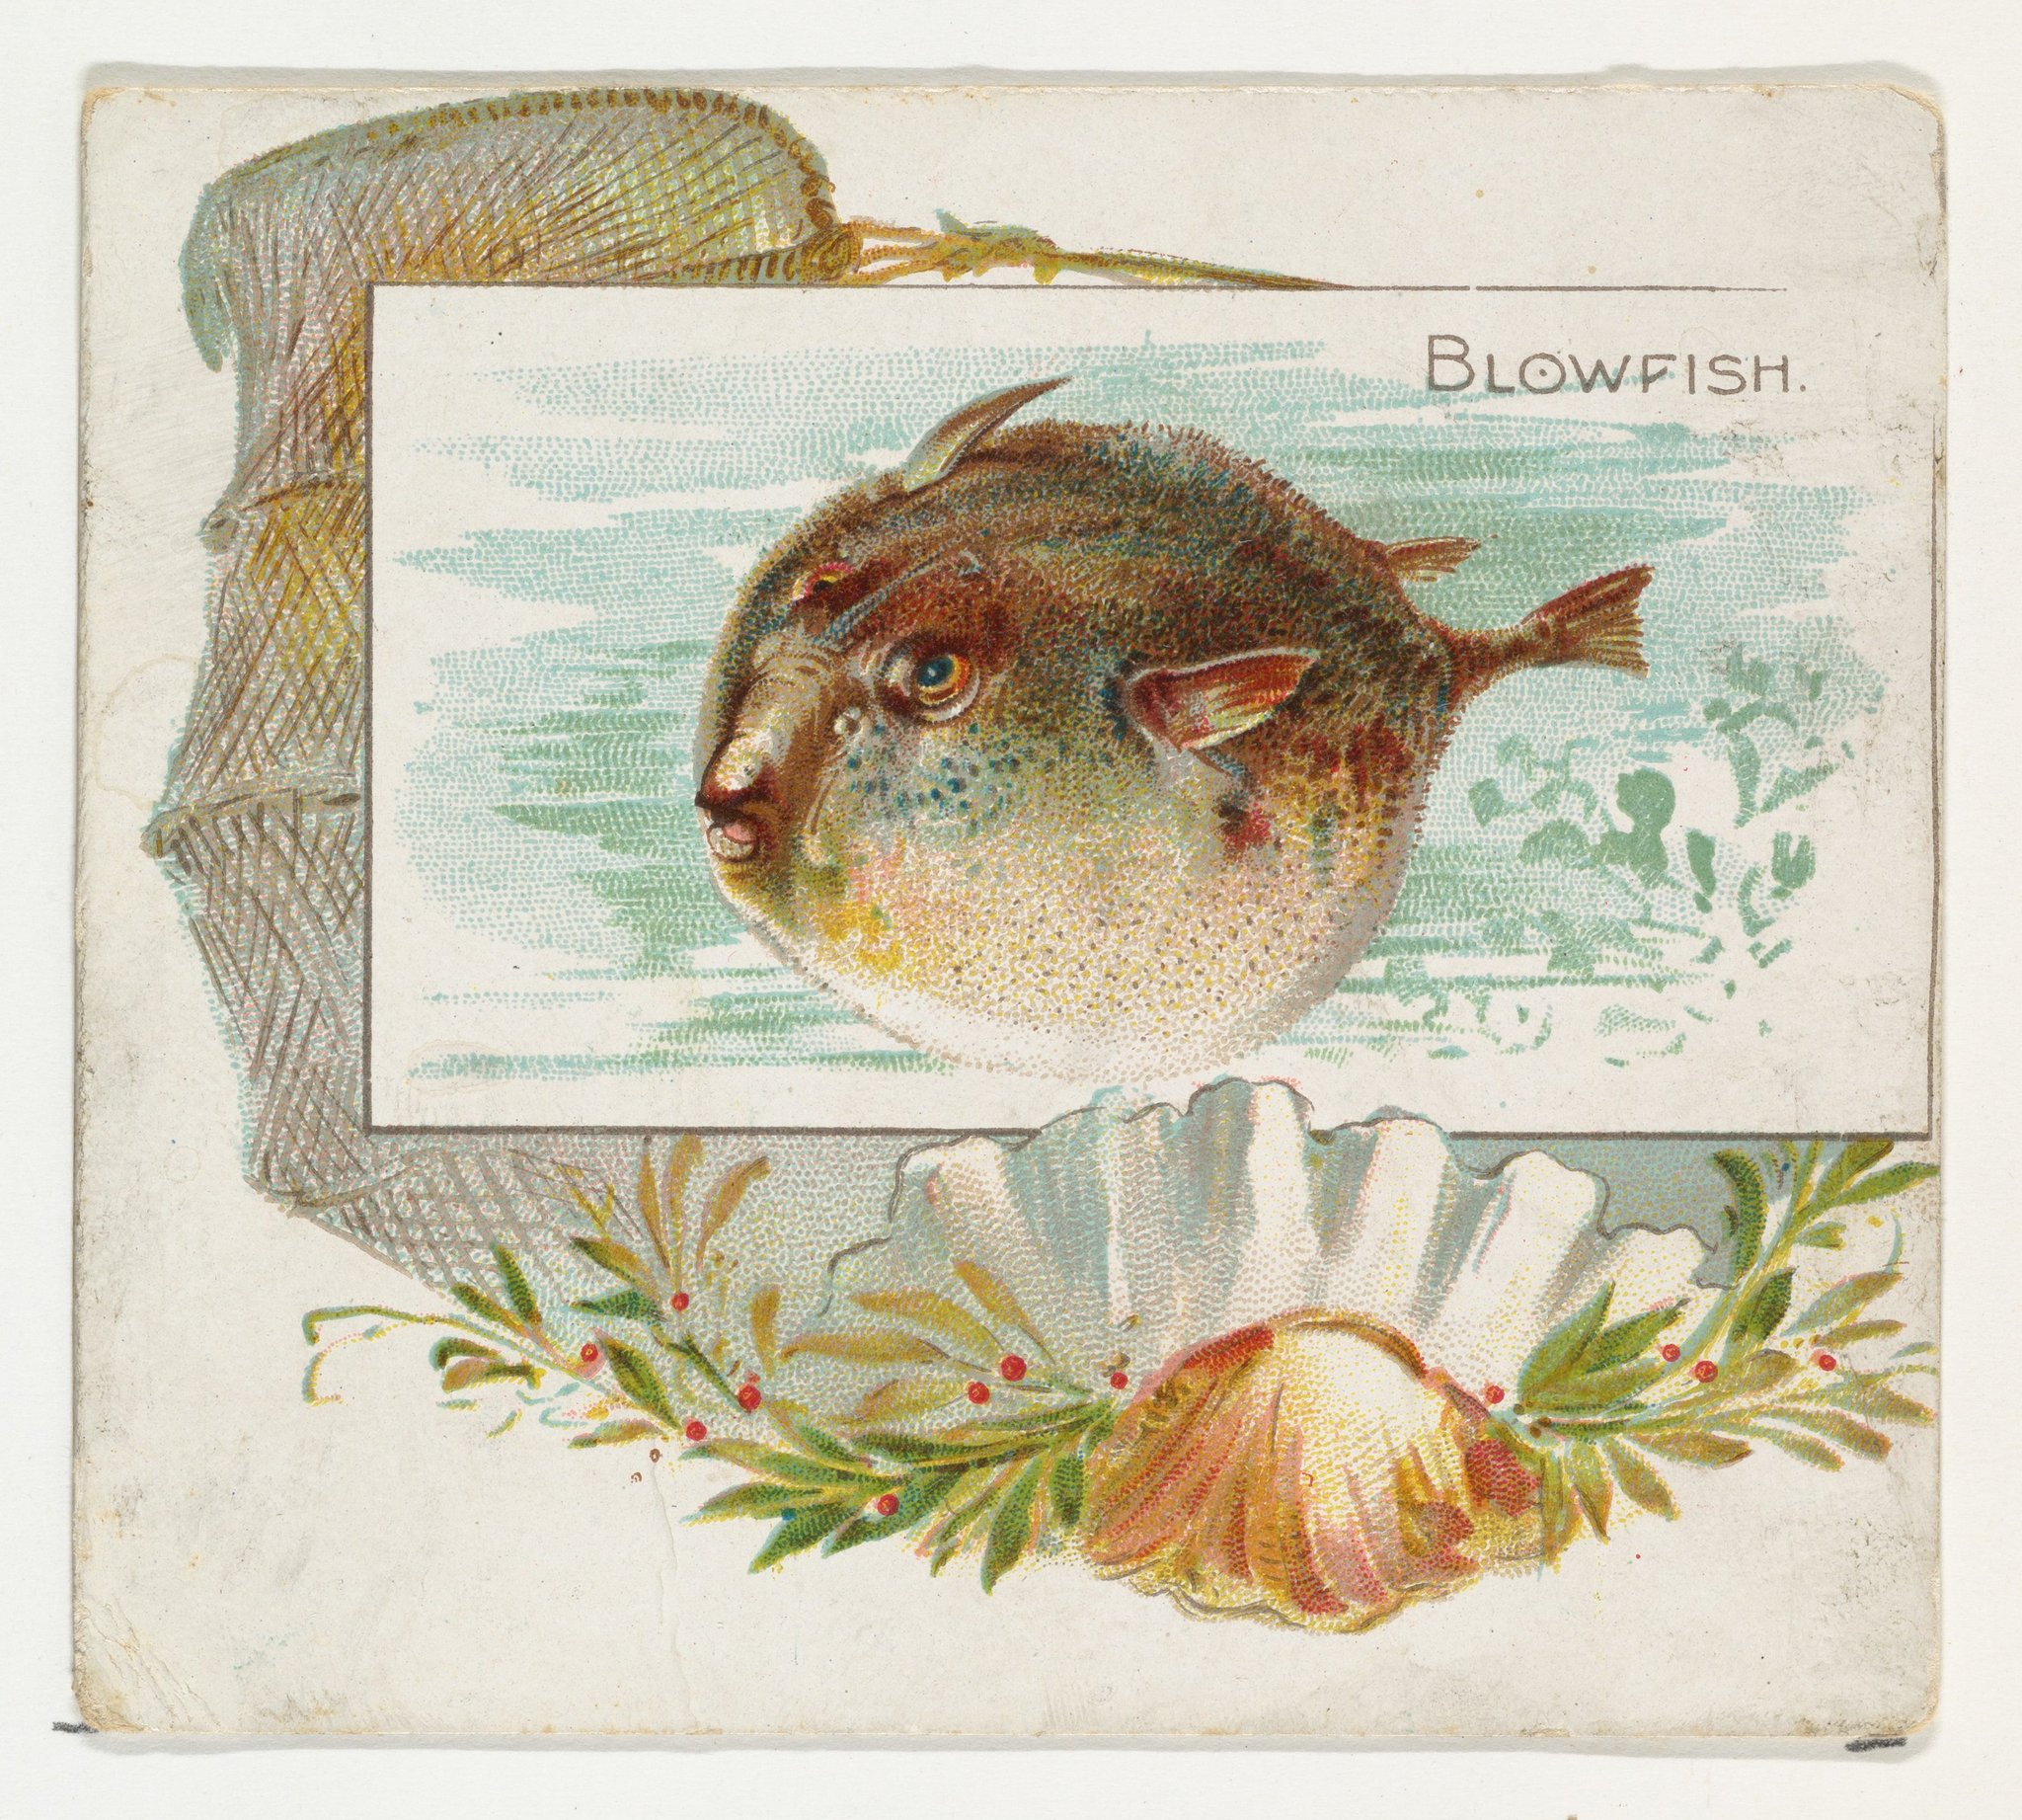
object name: print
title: Blowfish, from Fish from American Waters series (N39) for Allen & Ginter Cigarettes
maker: allen & ginter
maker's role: publisher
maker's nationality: american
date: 1889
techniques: color lithograph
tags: fish